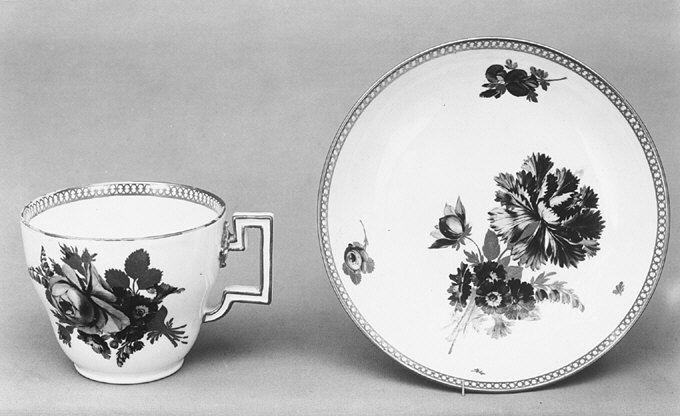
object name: cup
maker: meissen manufactory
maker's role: manufactory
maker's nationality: german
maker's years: 1710-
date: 1796-1814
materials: hard paste porcelain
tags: flowers